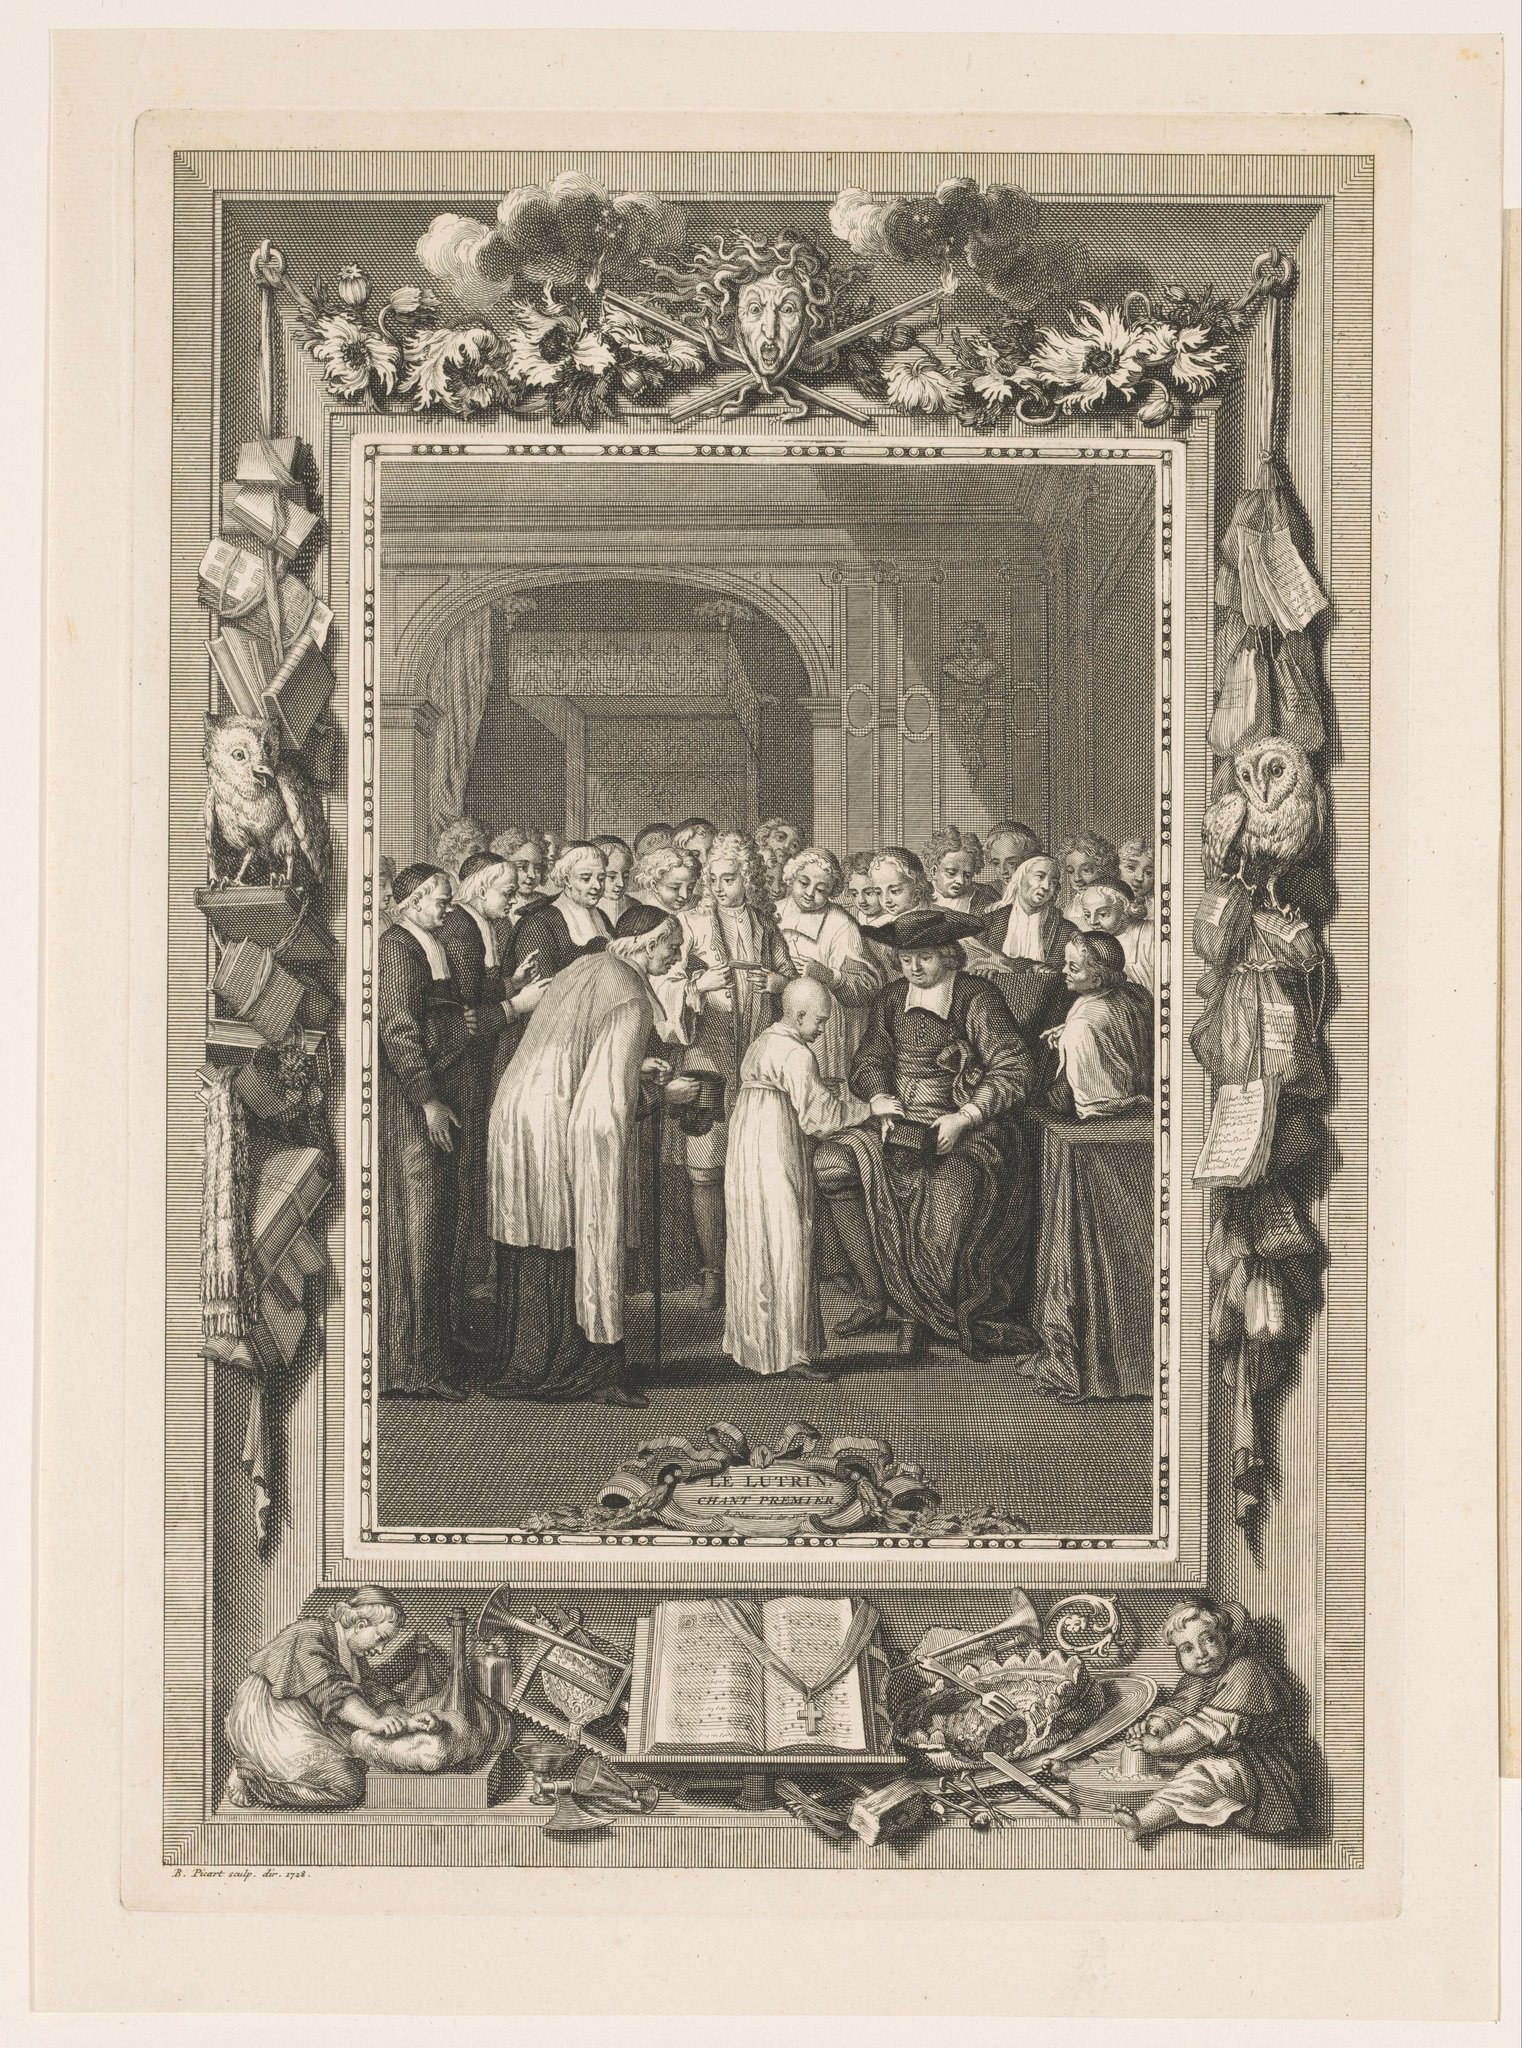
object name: print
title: Le Lutrin. Chant Premier.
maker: bernard picart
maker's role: draughtsman, print maker, publisher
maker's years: 1673-1733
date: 1717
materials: paper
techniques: engraving, etching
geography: amsterdam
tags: head-gear, insignia of bishop, e.g. mitre, crozier, gorgoneion, head of medusa, organization, functionaries and dignitaries in roman catholic church; clergy in general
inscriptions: collector's mark: Lugt 2228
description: Een groep geestelijken kijkt toe hoe een jonge misdienaar uit de biretta van de priester een papier pakt. De voorstelling is gedecoreerd met een ornamentele omlijsting die wordt bekroond door een Medusahoofd. Onderaan een opengeslagen liedboek en diverse attributen van een bisschop.